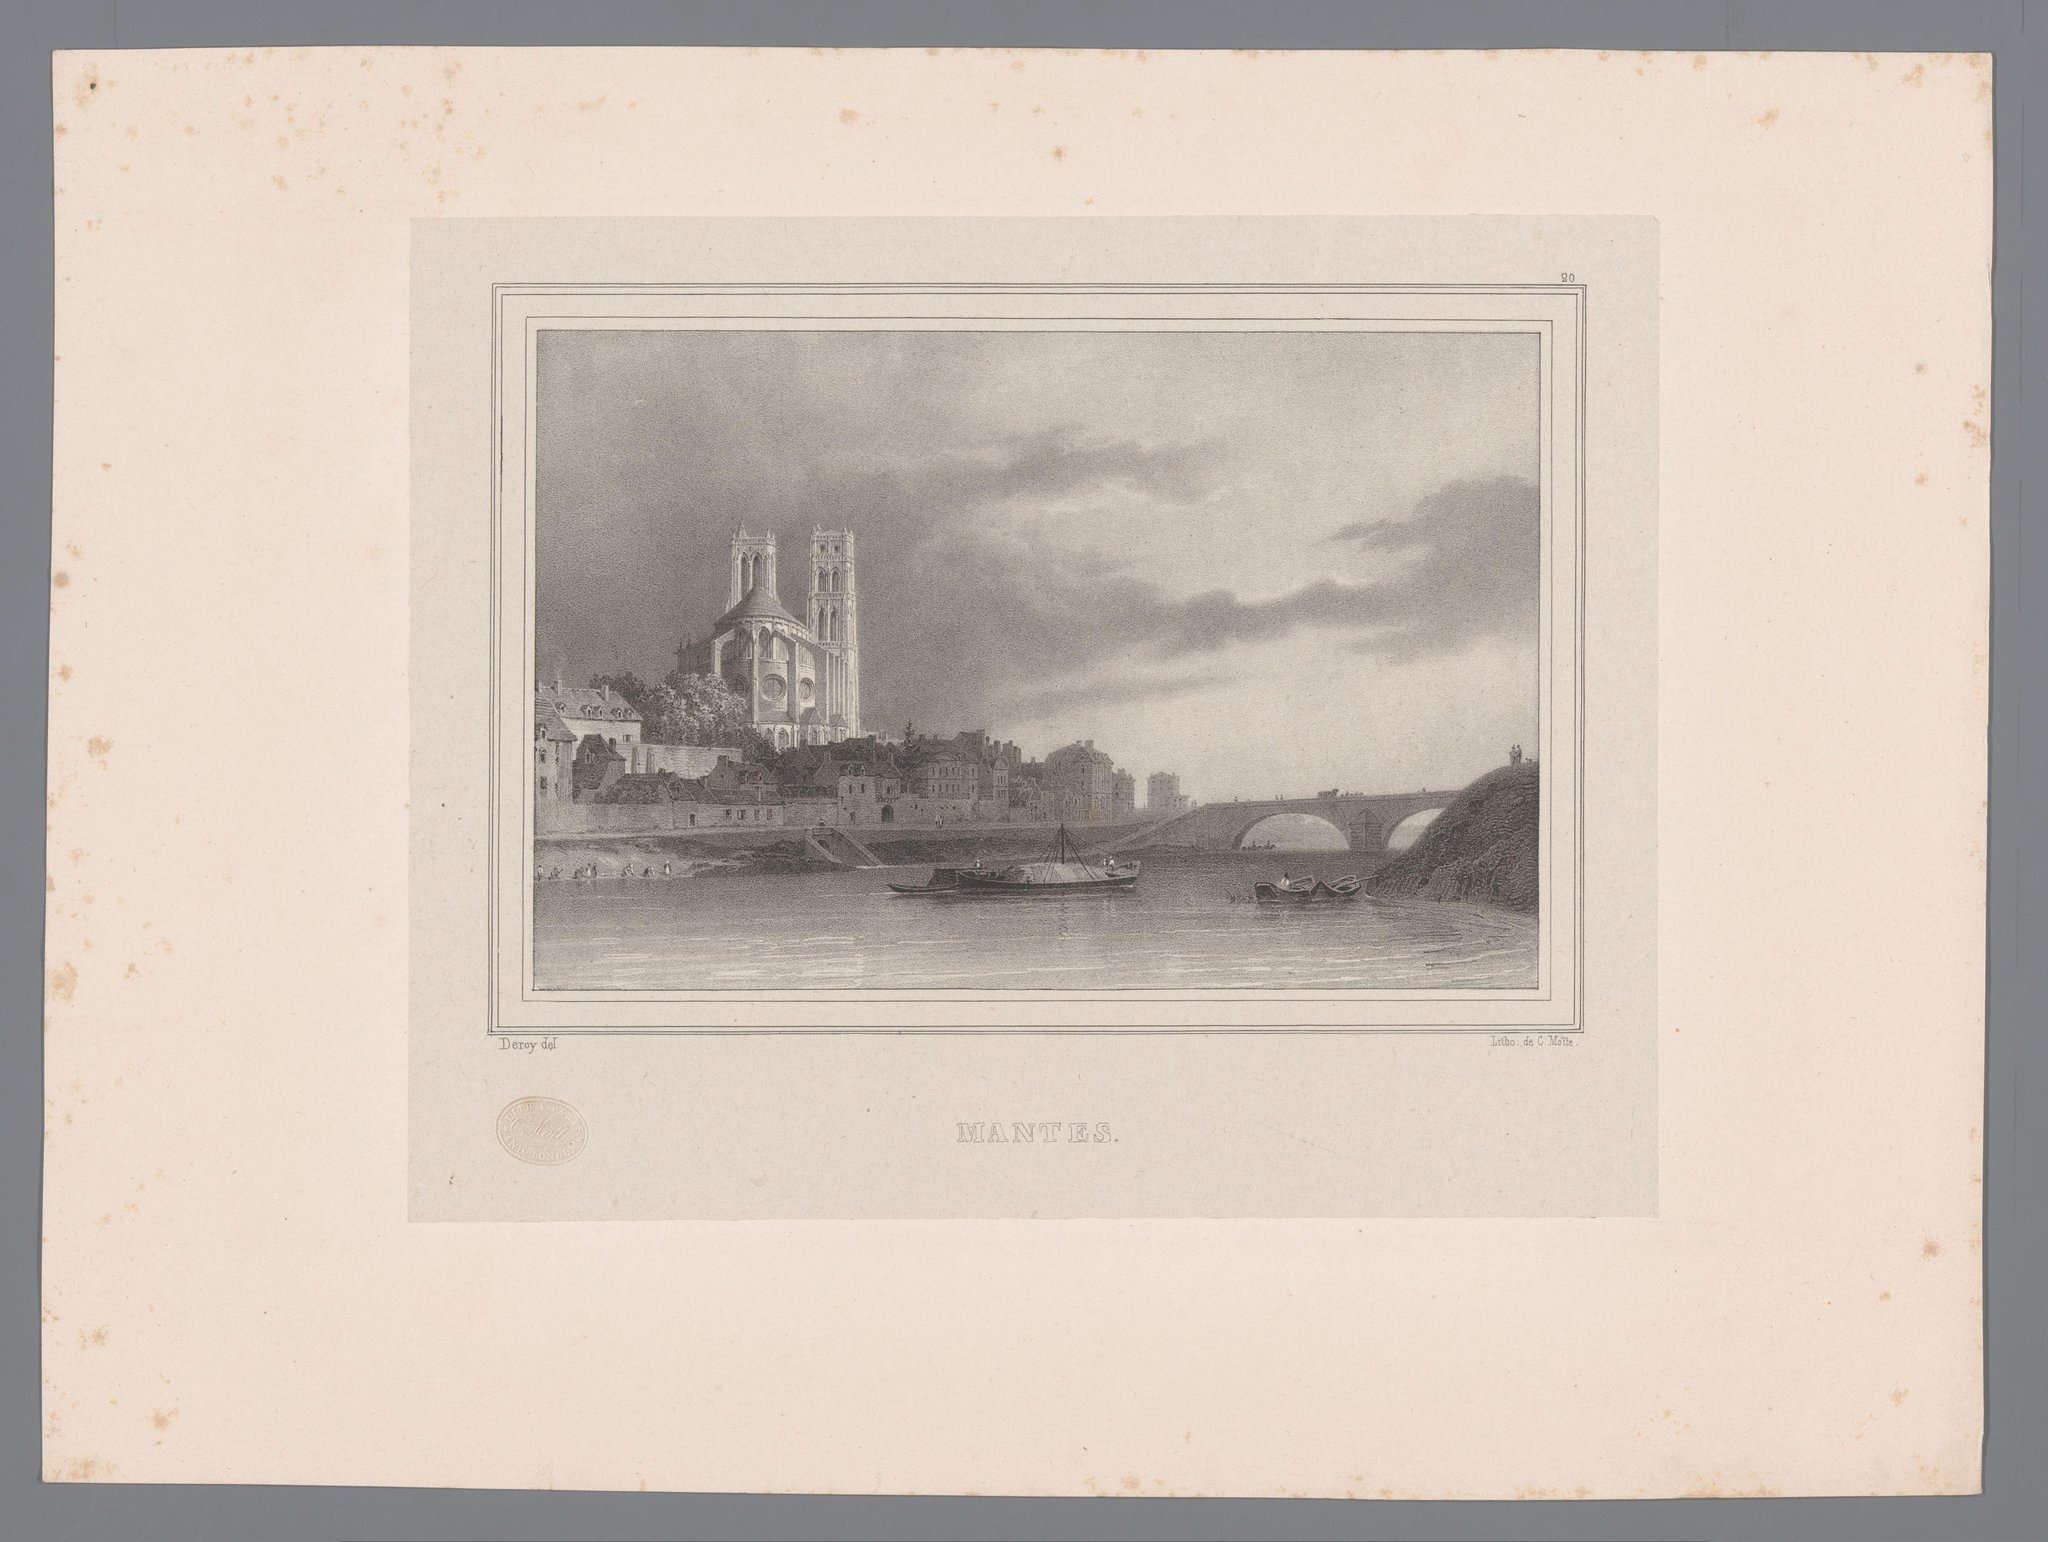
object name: print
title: Gezichten aan de oevers van de Seine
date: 1829-1831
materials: paper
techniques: lithograph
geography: mantes-la-jolie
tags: bridge in city across river, canal, etc., river (+ landscape with figures, staffage), prospect of city, town panorama, silhouette of city (+ city(-scape) with figures, staffage)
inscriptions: collector's mark: Lugt 2228a, check stamp: Lugt 1828b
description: Prent maakt deel uit van een omslag met twaalf prenten.